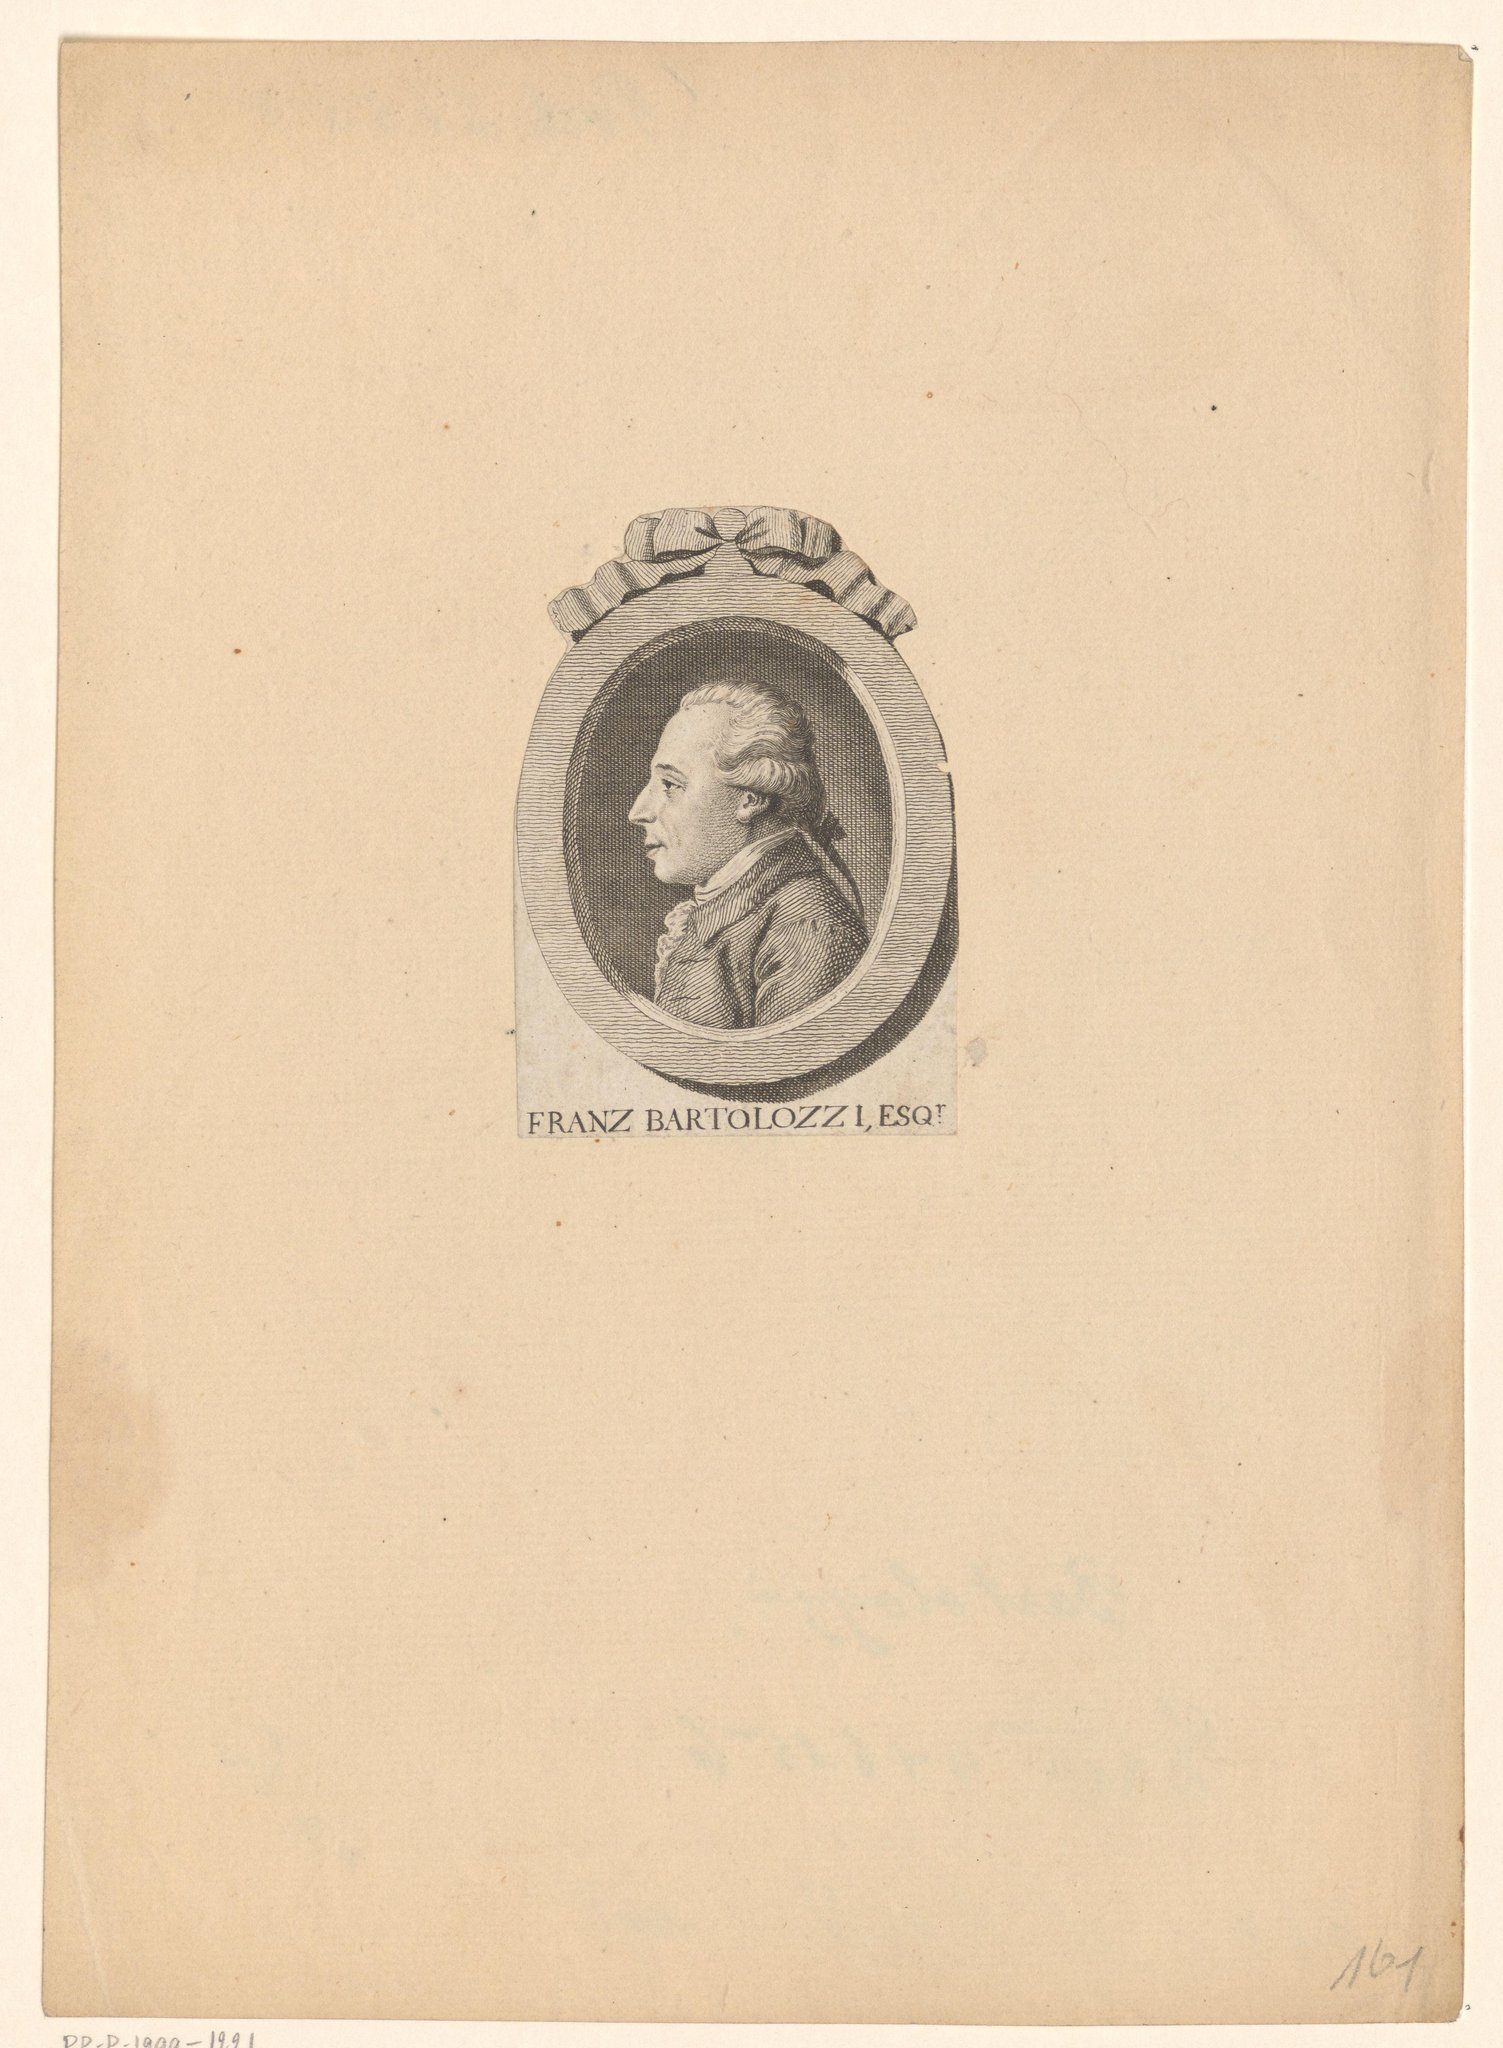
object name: print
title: Portret van Francesco Bartolozzi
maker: Anonymous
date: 1764-1810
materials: paper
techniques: engraving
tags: print maker, draughtsman, publisher, francesco bartolozzi, historical persons, portrait, self-portrait of artist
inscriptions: collector's mark: Lugt 2228, collector's mark: Lugt 2760